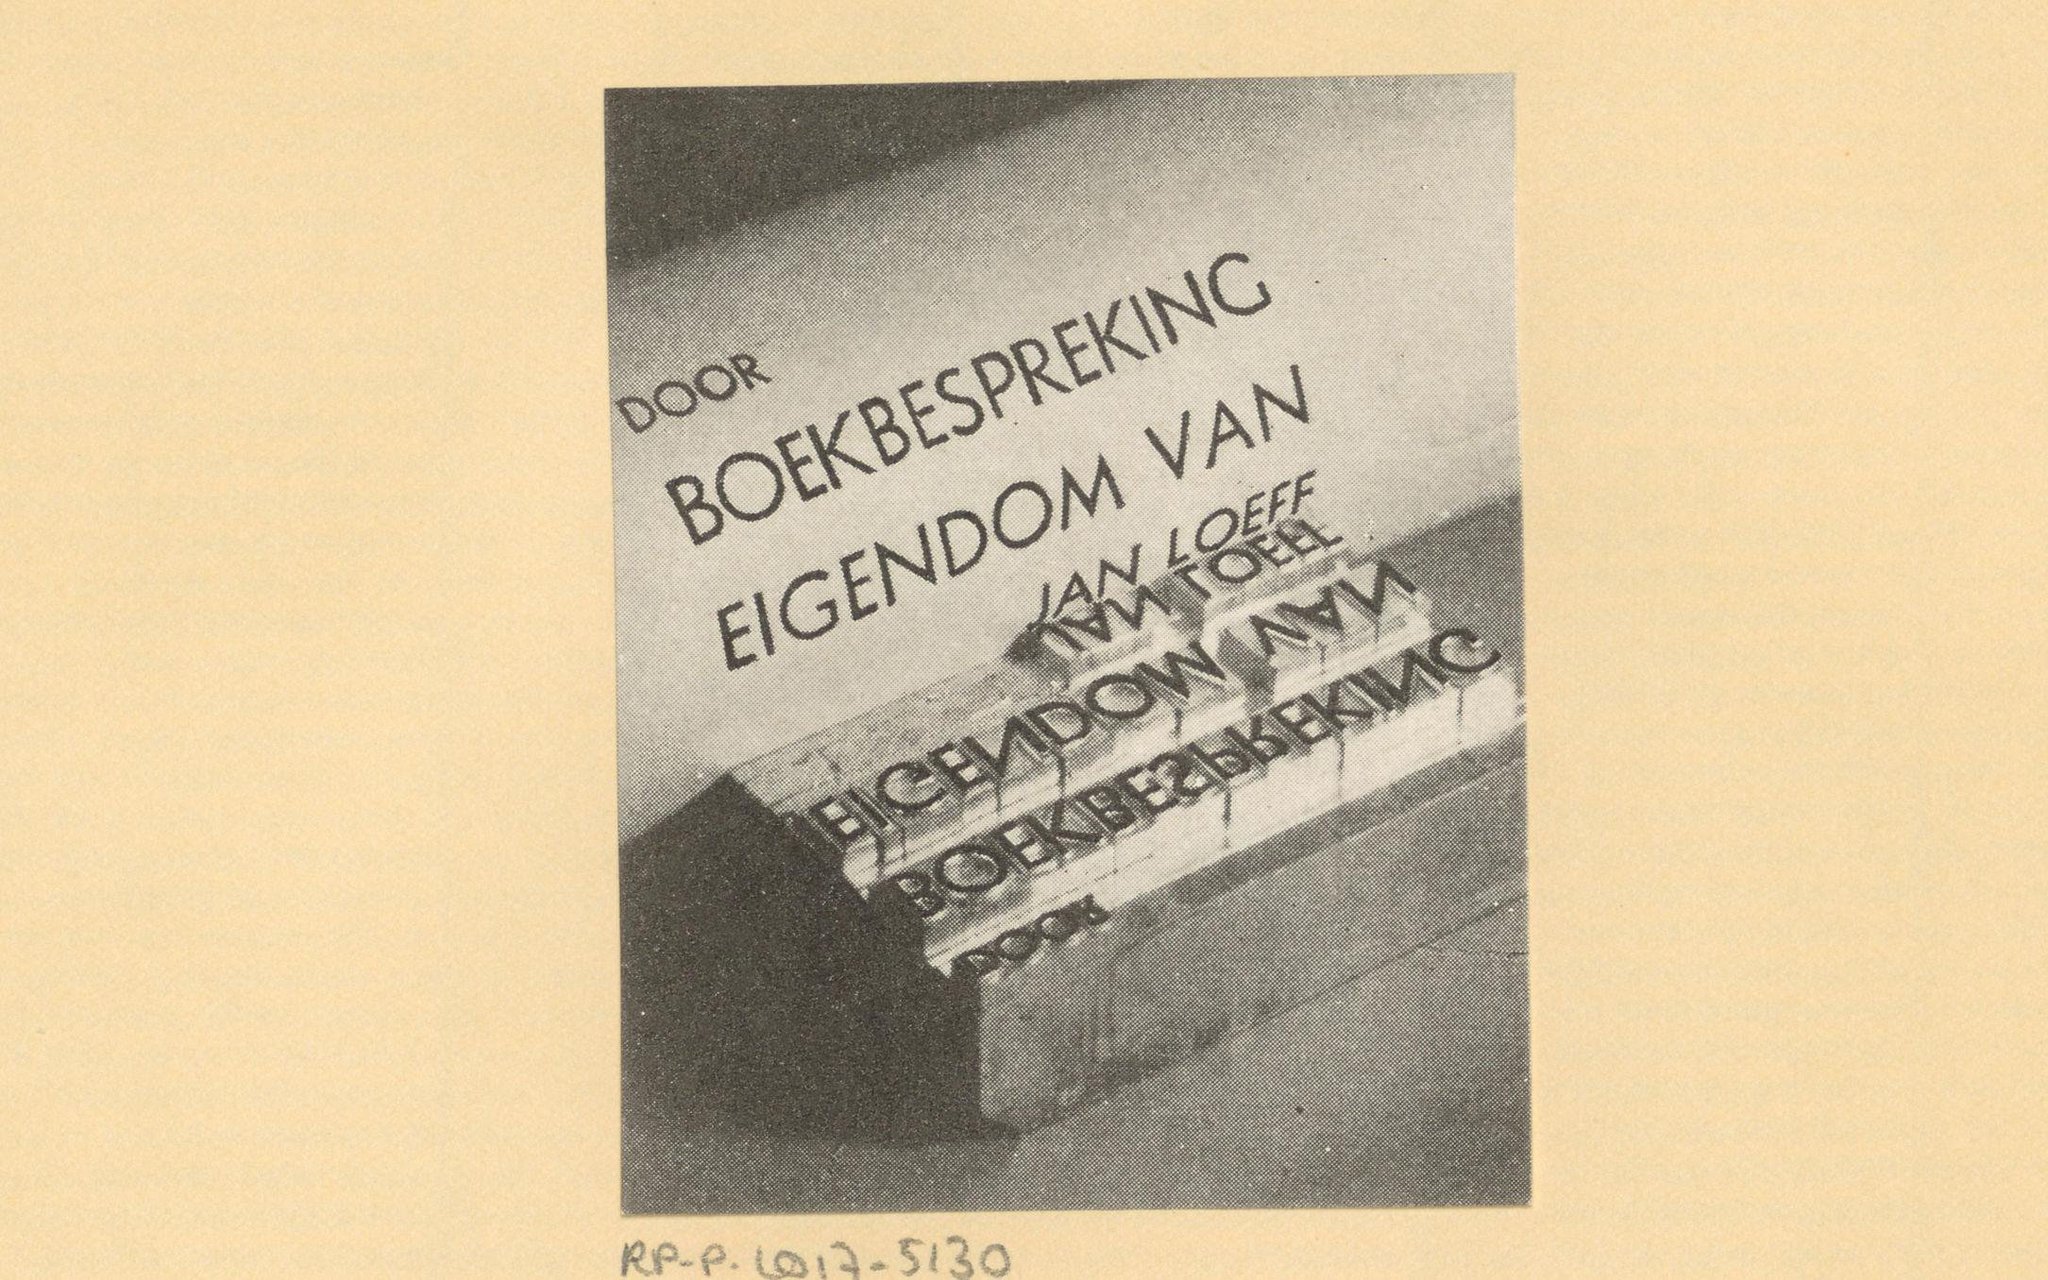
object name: bookplate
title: Ex libris van Jan Loeff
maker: Anonymous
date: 1935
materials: paper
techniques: autotype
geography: netherlands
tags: jan loeff, printing, printing office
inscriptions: inscription: ‘fotogr. ontwerp / 1935 / uit mijn / journalistentijd’